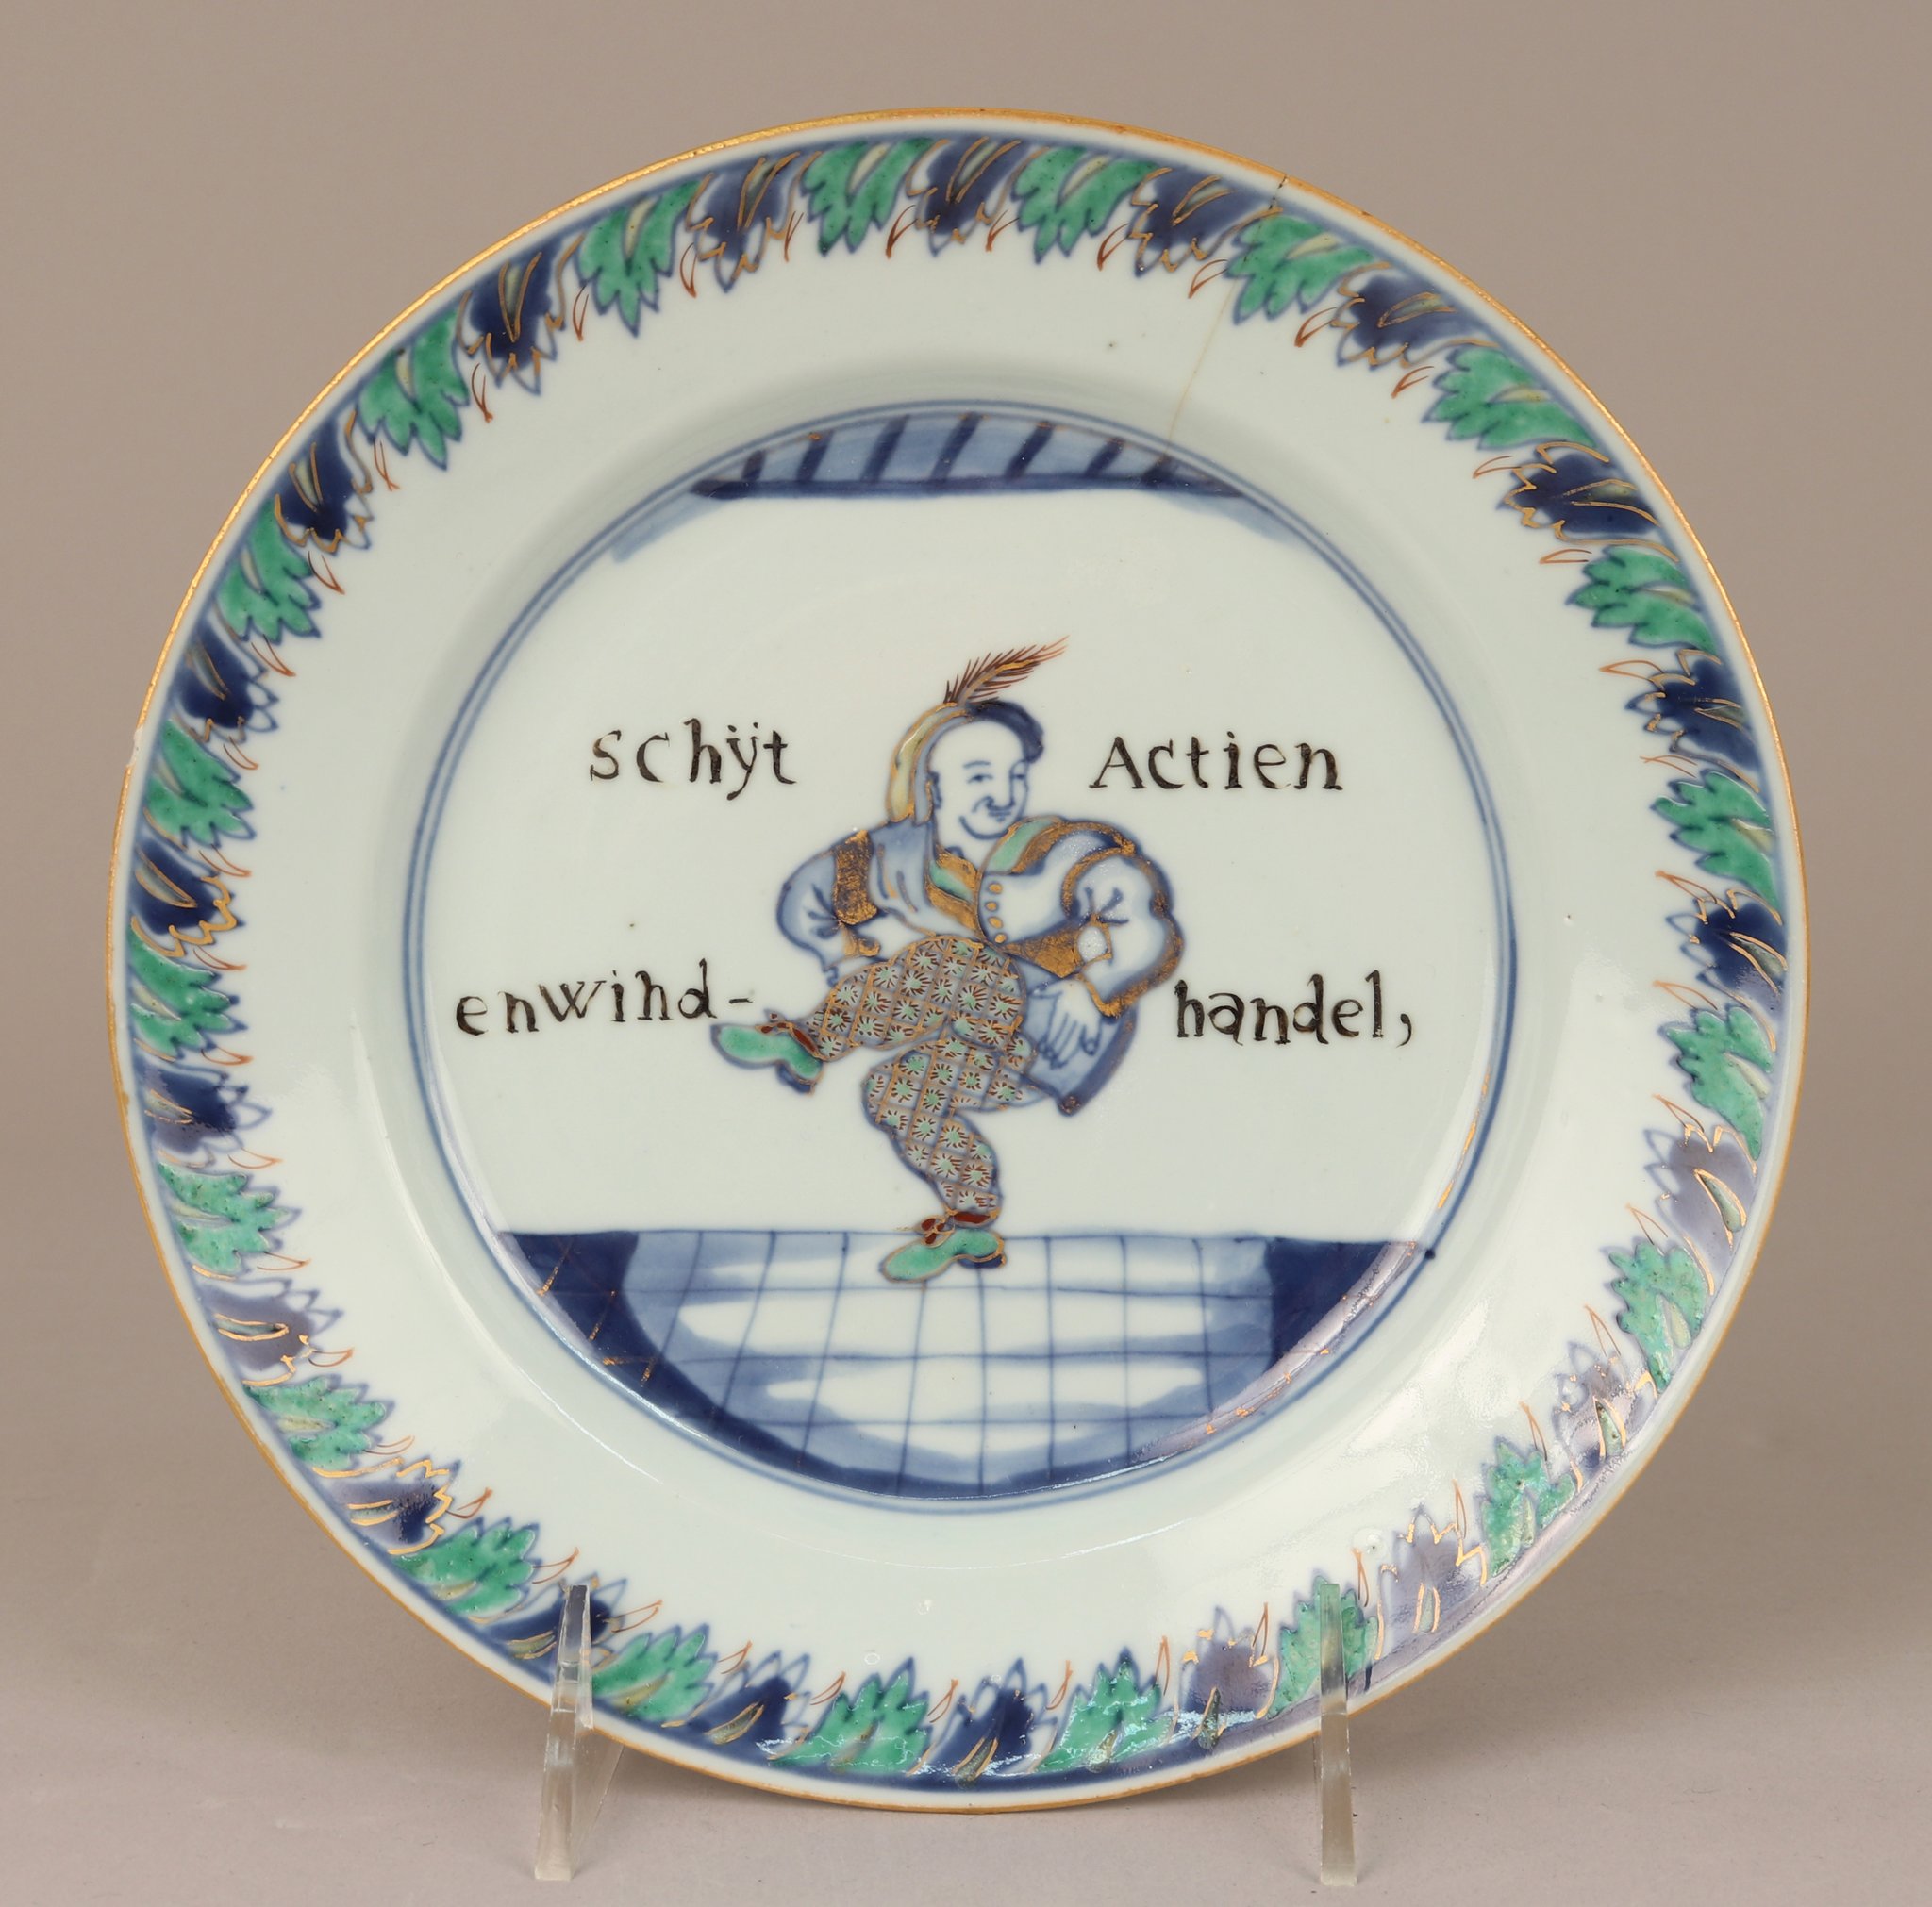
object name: plate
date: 1720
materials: hard paste porcelain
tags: men